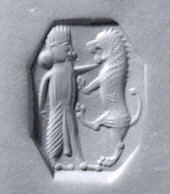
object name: stamp seal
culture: achaemenid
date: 500-201 BCE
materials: stone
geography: syria or anatolia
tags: men,lions